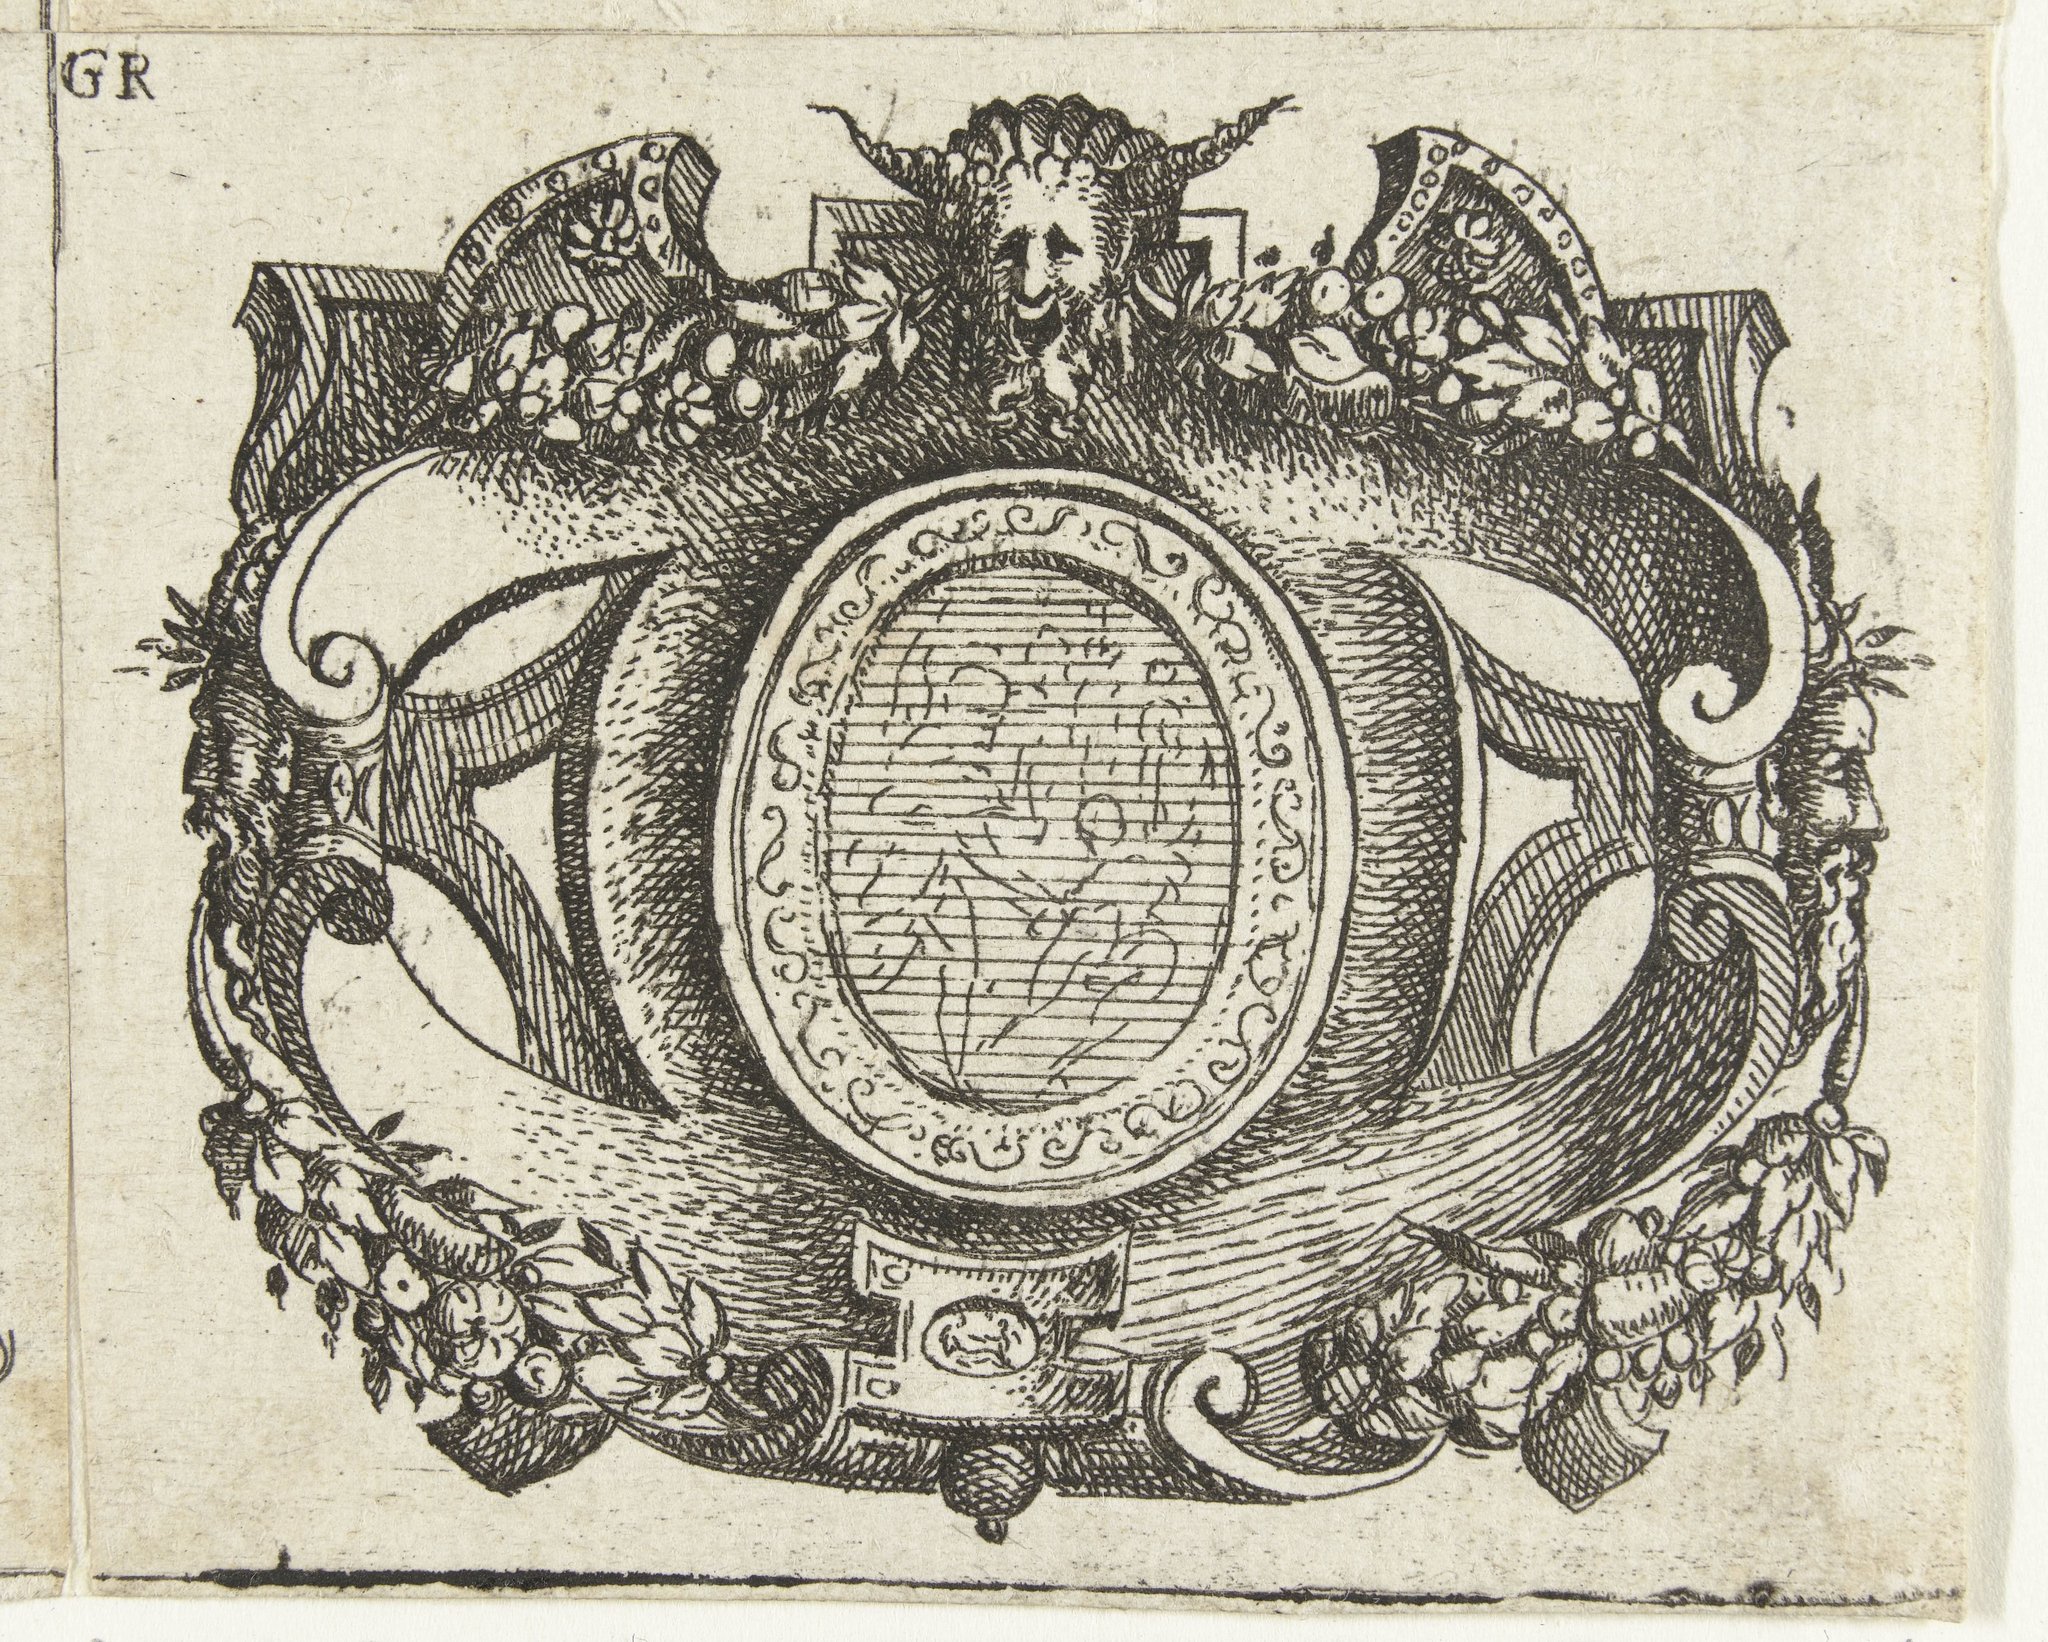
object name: print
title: Cartouche in vorm van staand ovaal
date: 1500-1600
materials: paper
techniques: etching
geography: france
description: De cartouche is omlijst door rolwerk in de vorm van een liggend ovaal. Middenboven en links en rechts hangen mascarons. Uit serie van 17 bladen.